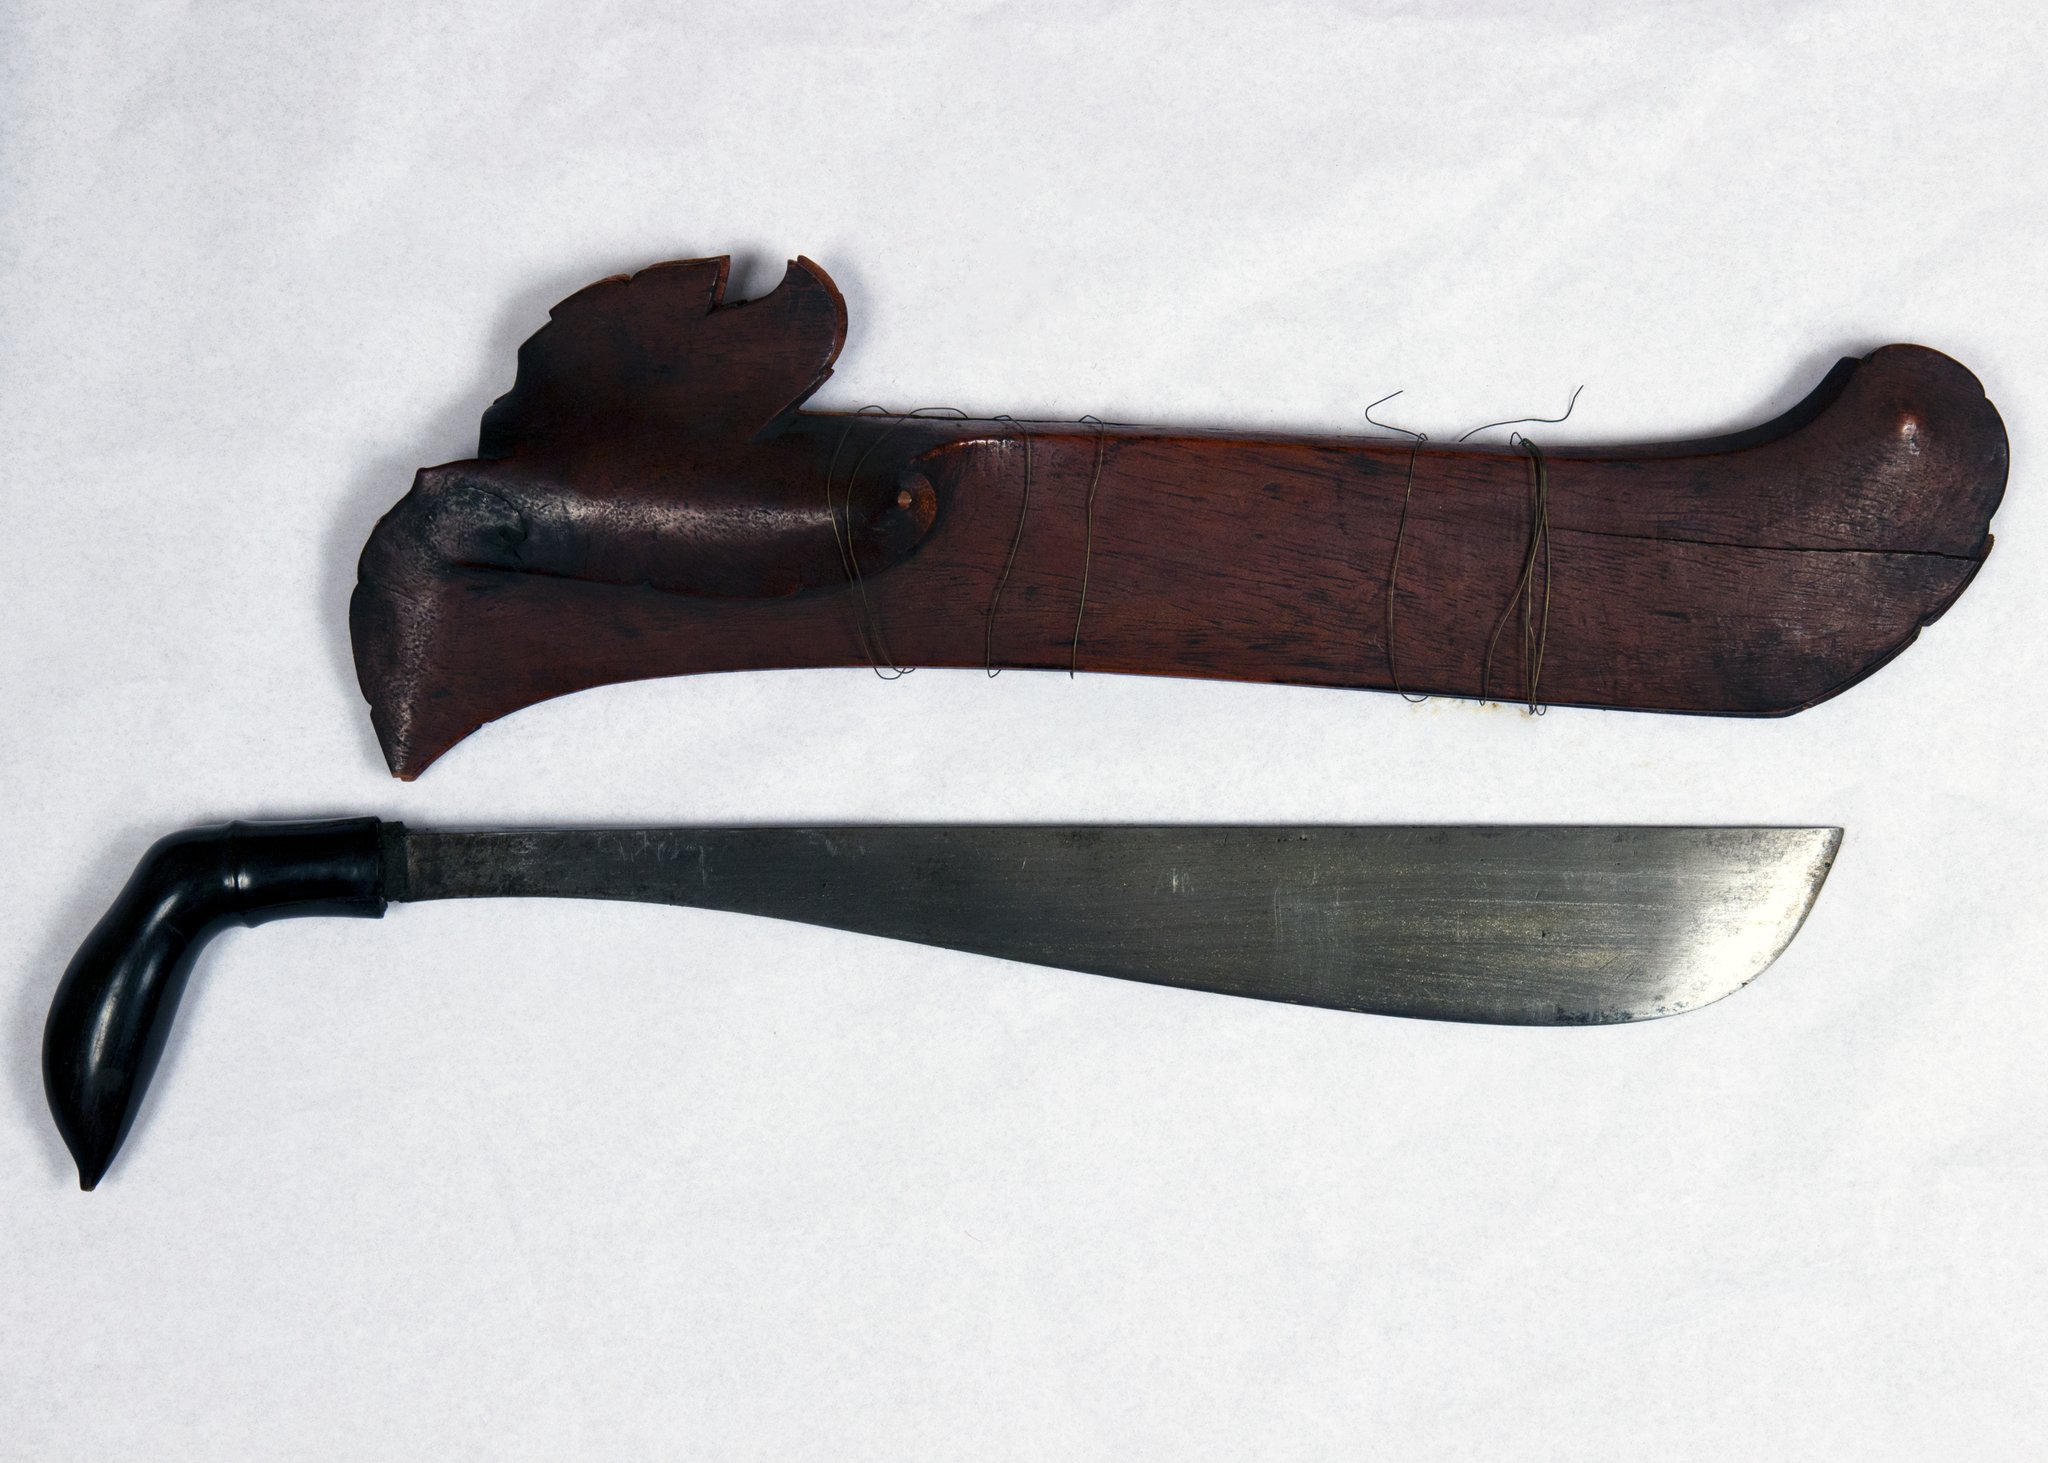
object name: knife parang with sheath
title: Knife (Parang) with Sheath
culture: malayan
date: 1701-1900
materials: horn, wood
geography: malaysia